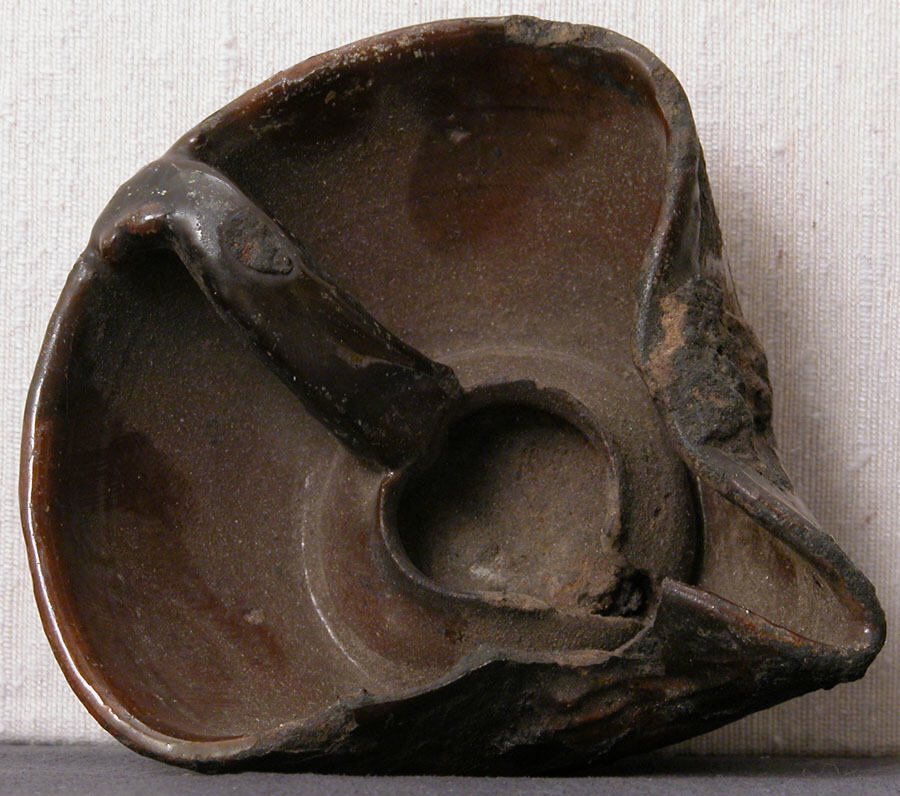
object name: lamp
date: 1201-1400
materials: earthenware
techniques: glazing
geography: syria